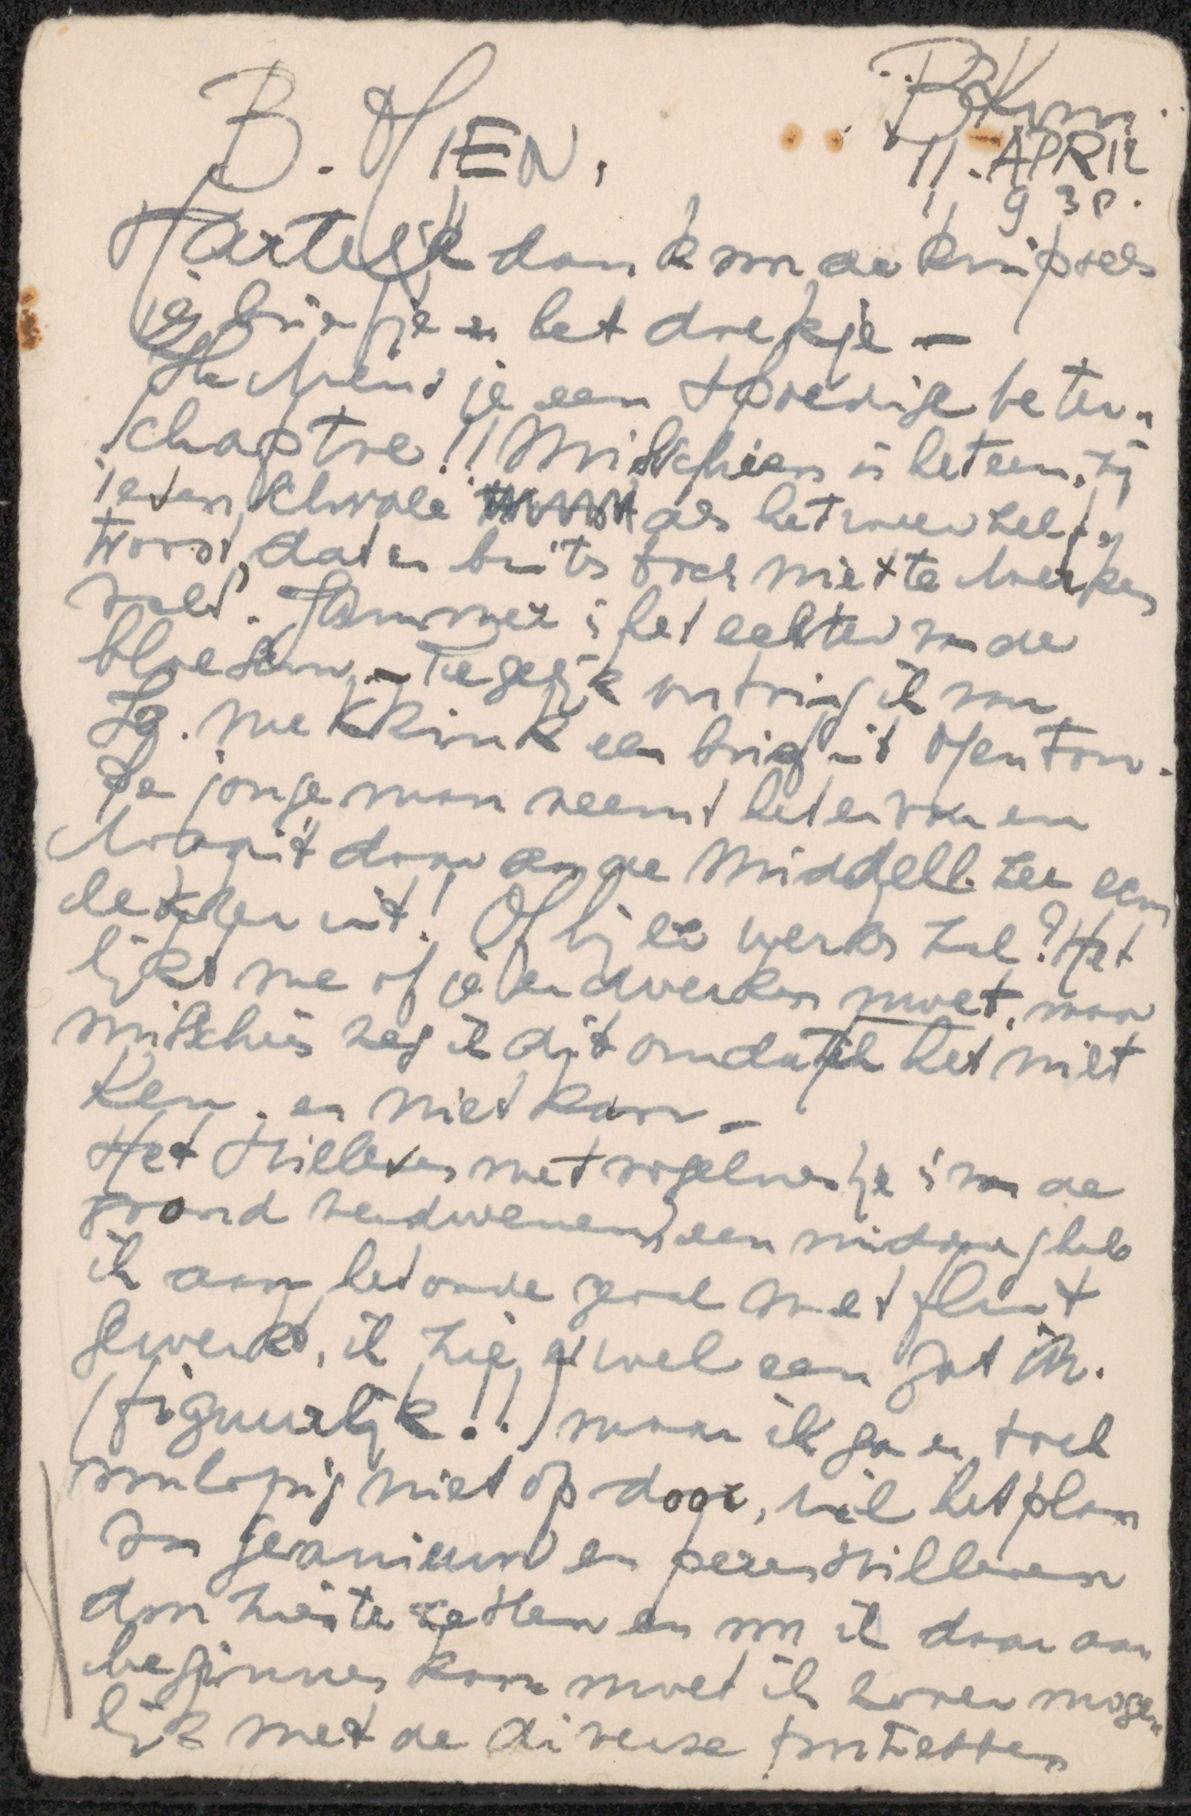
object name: letter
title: Brief aan Mien Cambier van Nooten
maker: dick ket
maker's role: draughtsman, print maker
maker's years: 1902-1940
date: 1938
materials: cardboard, ink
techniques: pen, writing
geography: bennekom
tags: arnhem, mien cambier van nooten, haarlem, dollmaker, textile artist, nelly johanna hagelen-schilt, literature ~ arts, painting (including book-illumination, miniature-painting), historical persons (portraits and scenes from the life)